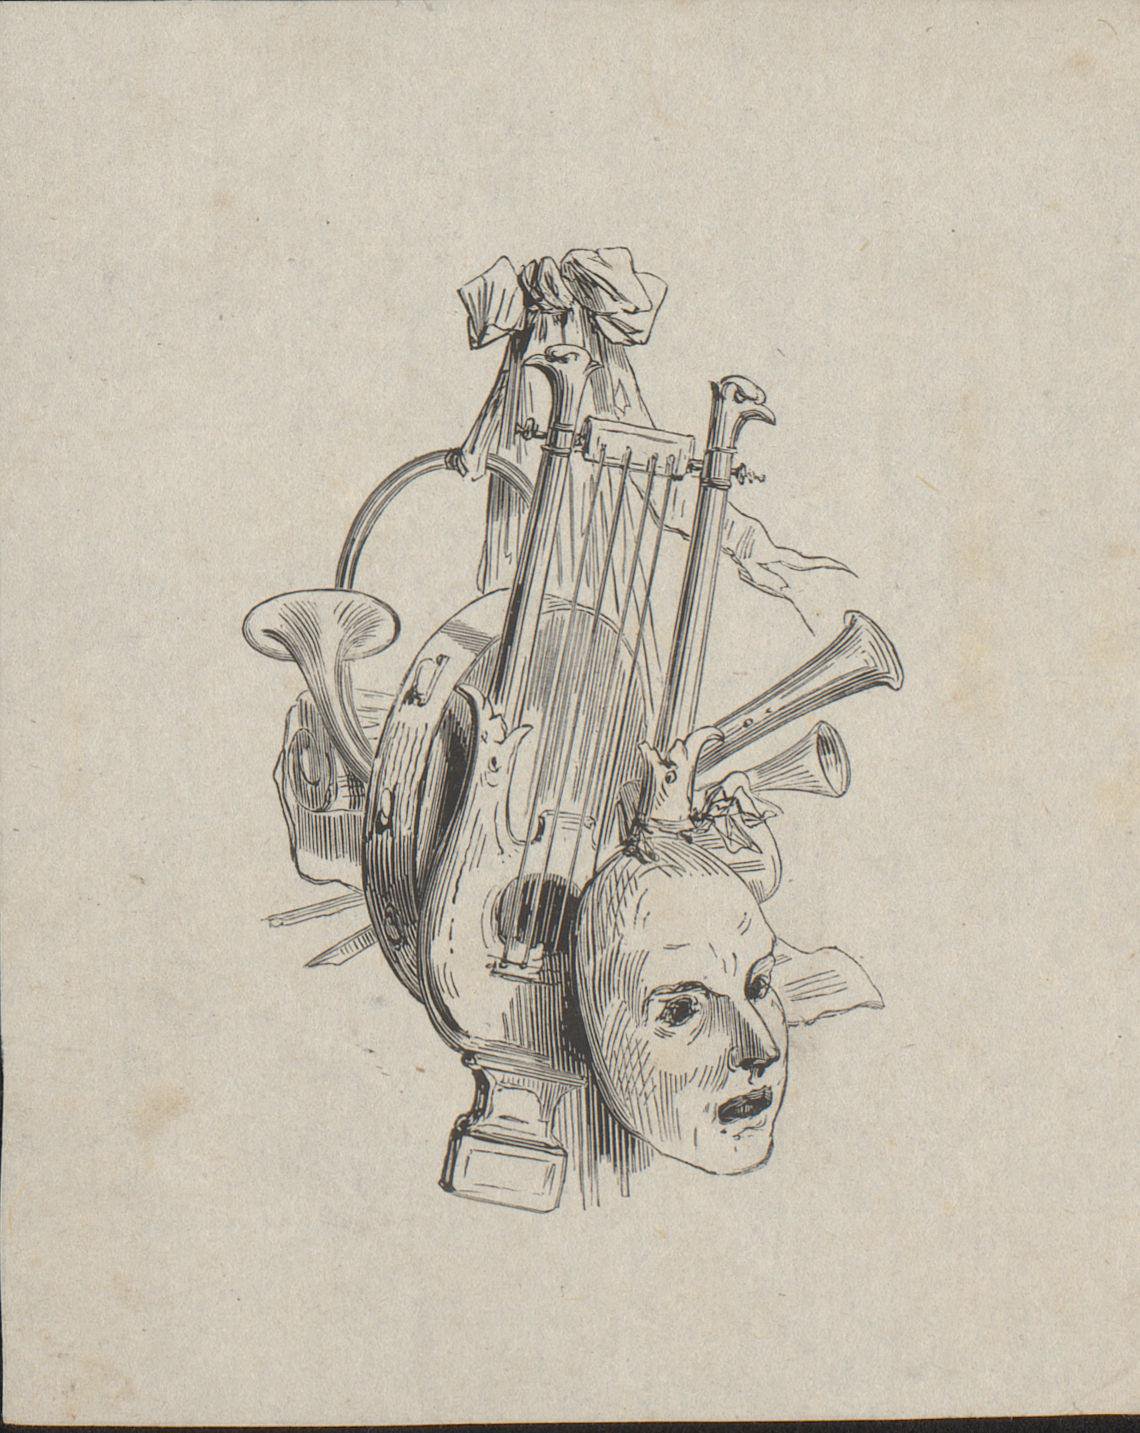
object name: print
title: Muziekinstrumenten en een masker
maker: isaac weissenbruch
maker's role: print maker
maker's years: 1826-1912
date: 1836-1912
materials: paper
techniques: engraving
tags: mask, musical instruments; group of musical instruments